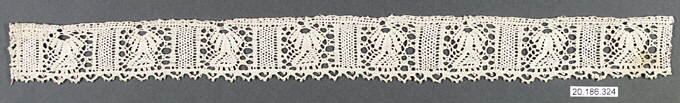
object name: edging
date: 1701-1800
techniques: lace